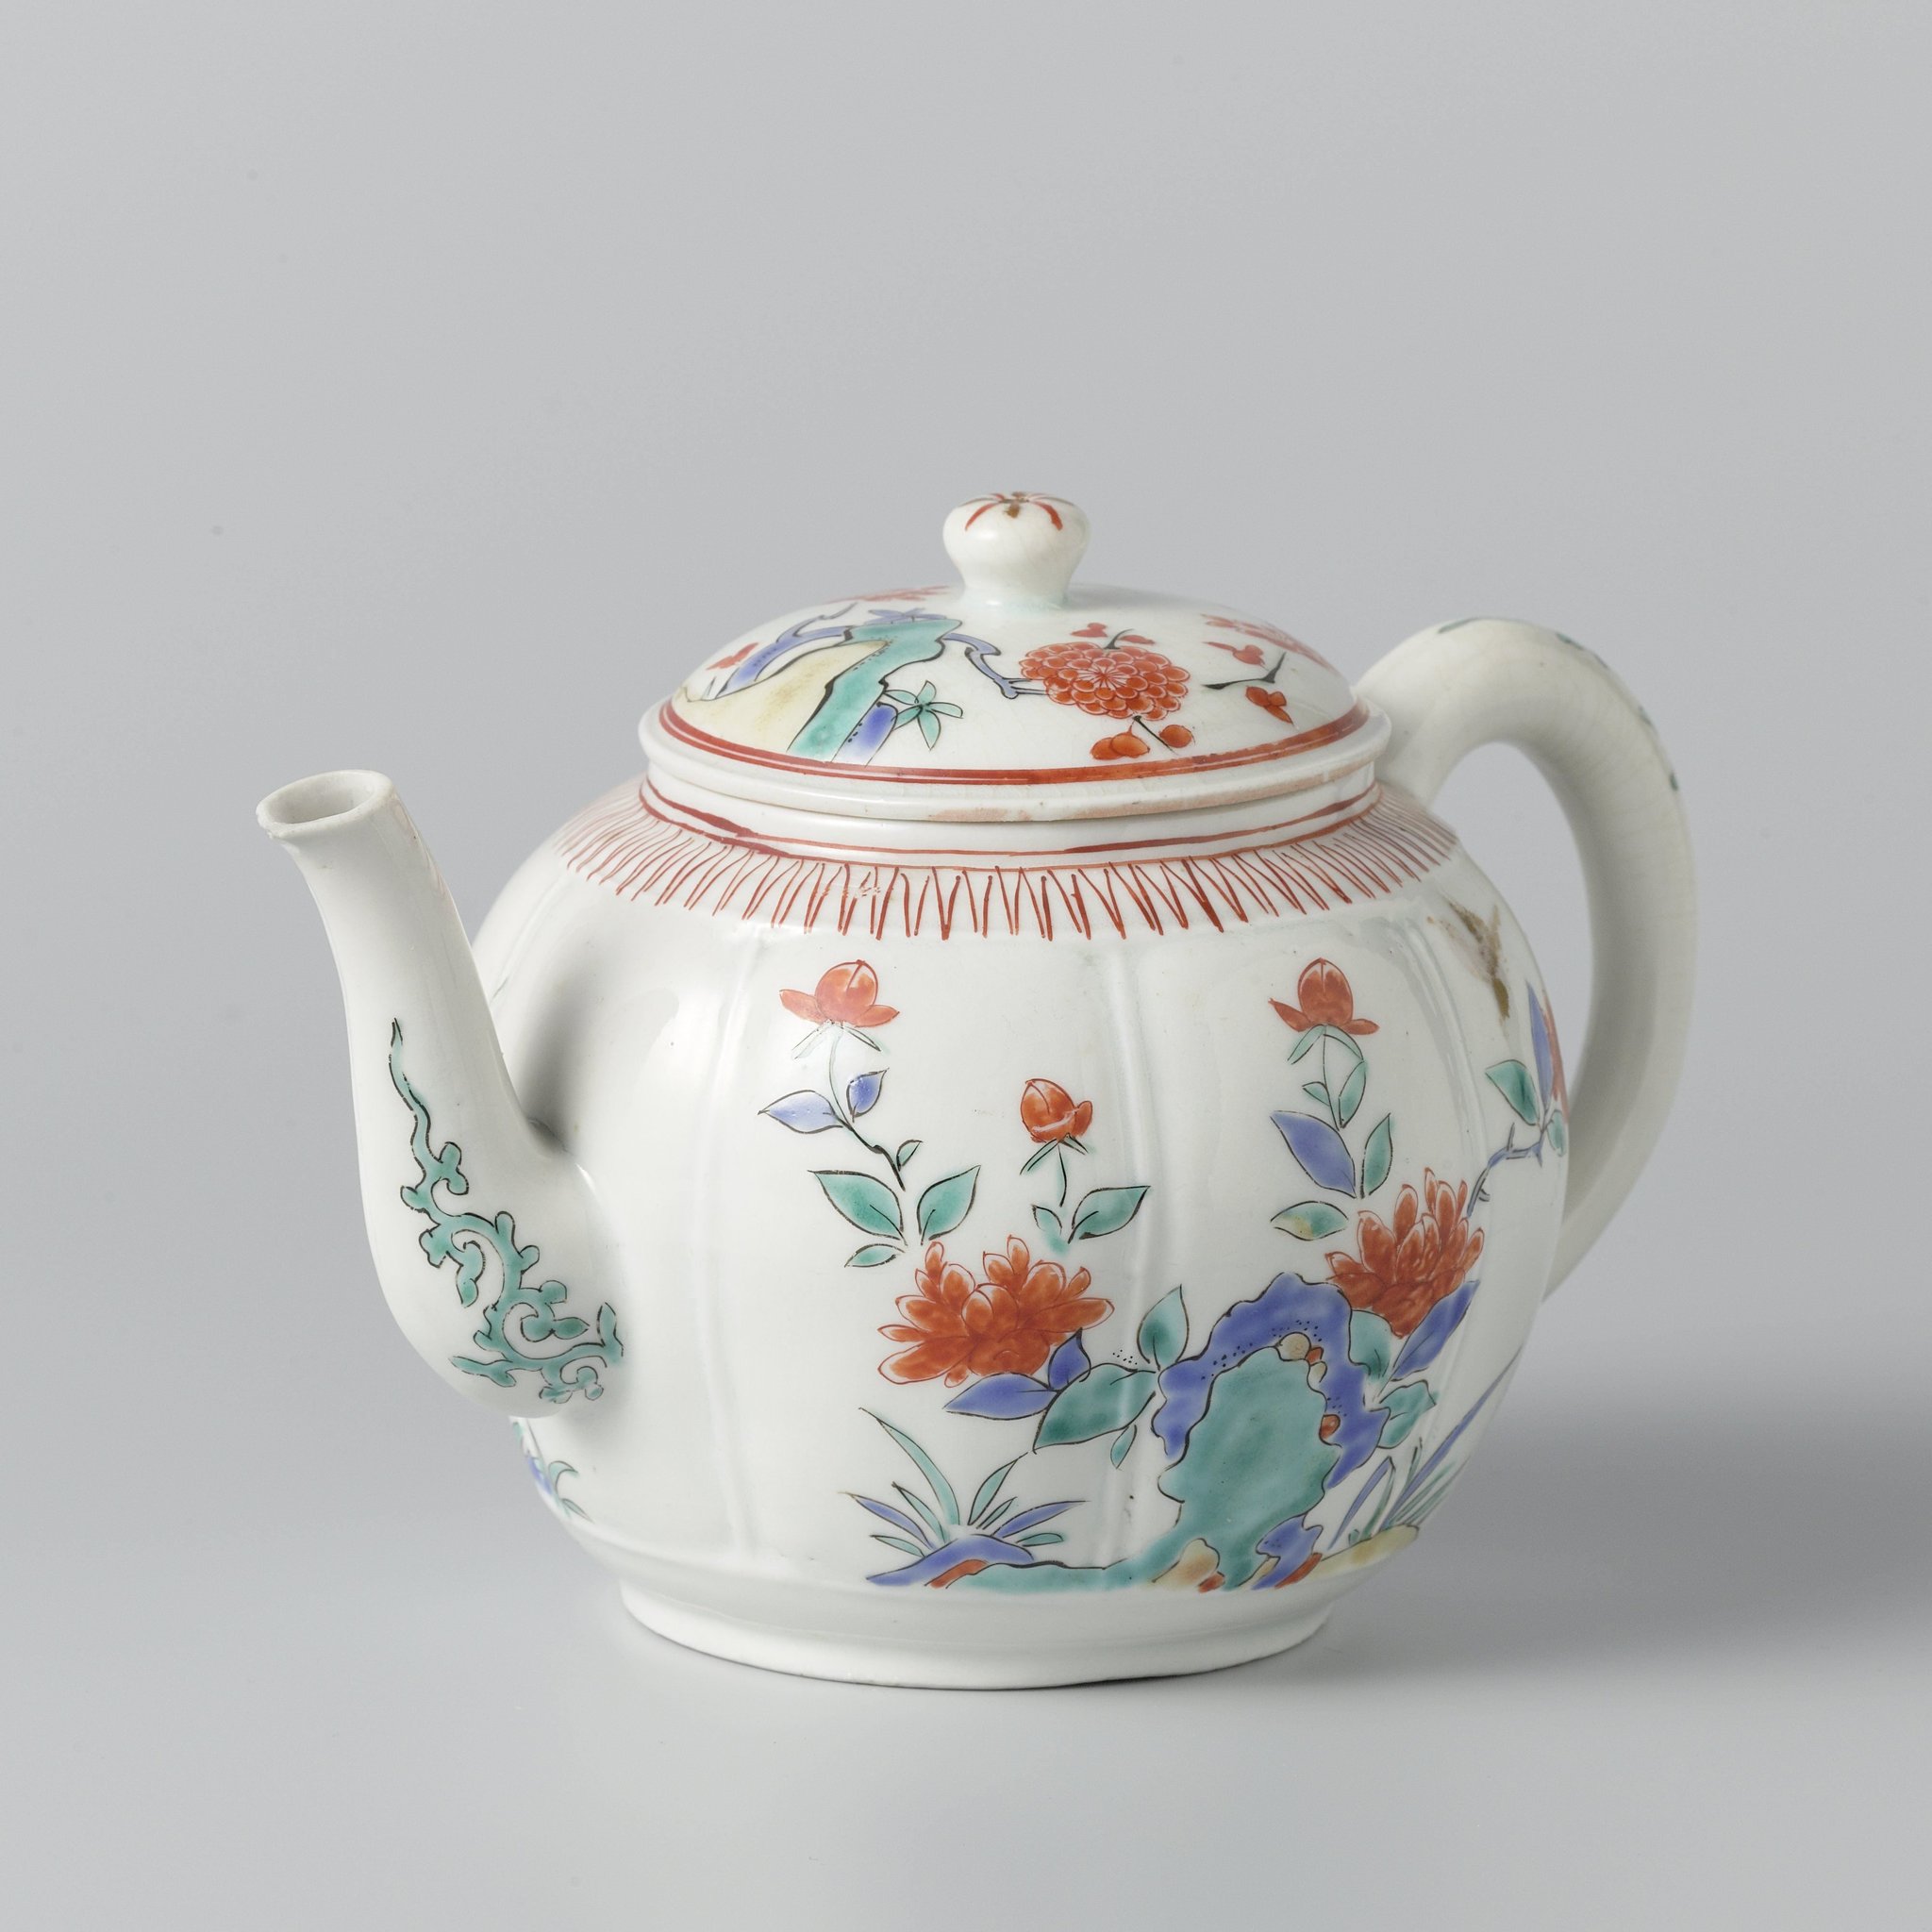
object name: teapot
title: Eight-lobed teapot with prunus, peony and floral scrolls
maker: Anonymous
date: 1670-1690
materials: glaze, gold, paint, porcelain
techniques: firing, gilding, turning, vitrification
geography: japan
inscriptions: label: ‘Collectie Westendorp/ 127’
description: Achtlobbige theepot van porselein, beschilderd op het glazuur in blauw, rood, geel, groen, zwart en goud. De achtlobbige buik is verdeeld in vakken door middel van verticale ribben. Op de buik aan de ene zijde een prunus bij een rots, aan de andere zijde een pioenrood. De tuit en het oor met bladranken. De deksel met een prunus bij een rots en een vliegende vogel. Chip in de tuit. Oud label op de onderzijde met 'Collectie Westendorp/ 127'. Arita, Kakiemon-stijl.